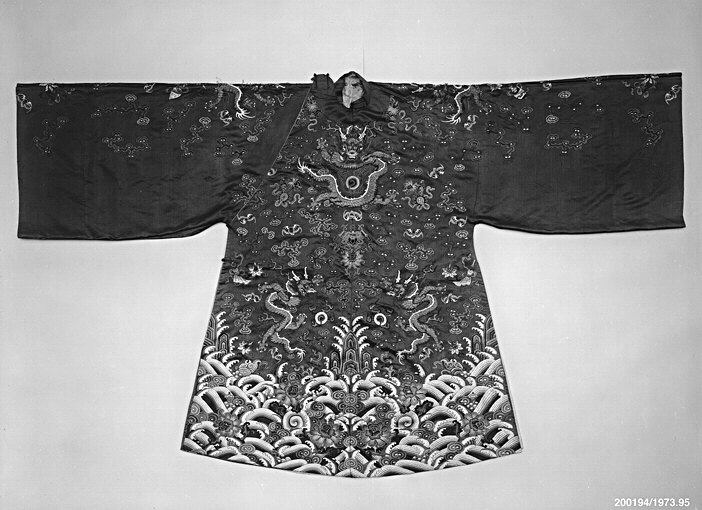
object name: five clawed dragon robe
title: Five-Clawed Dragon Robe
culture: chinese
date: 1736-1795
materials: silk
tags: dragons